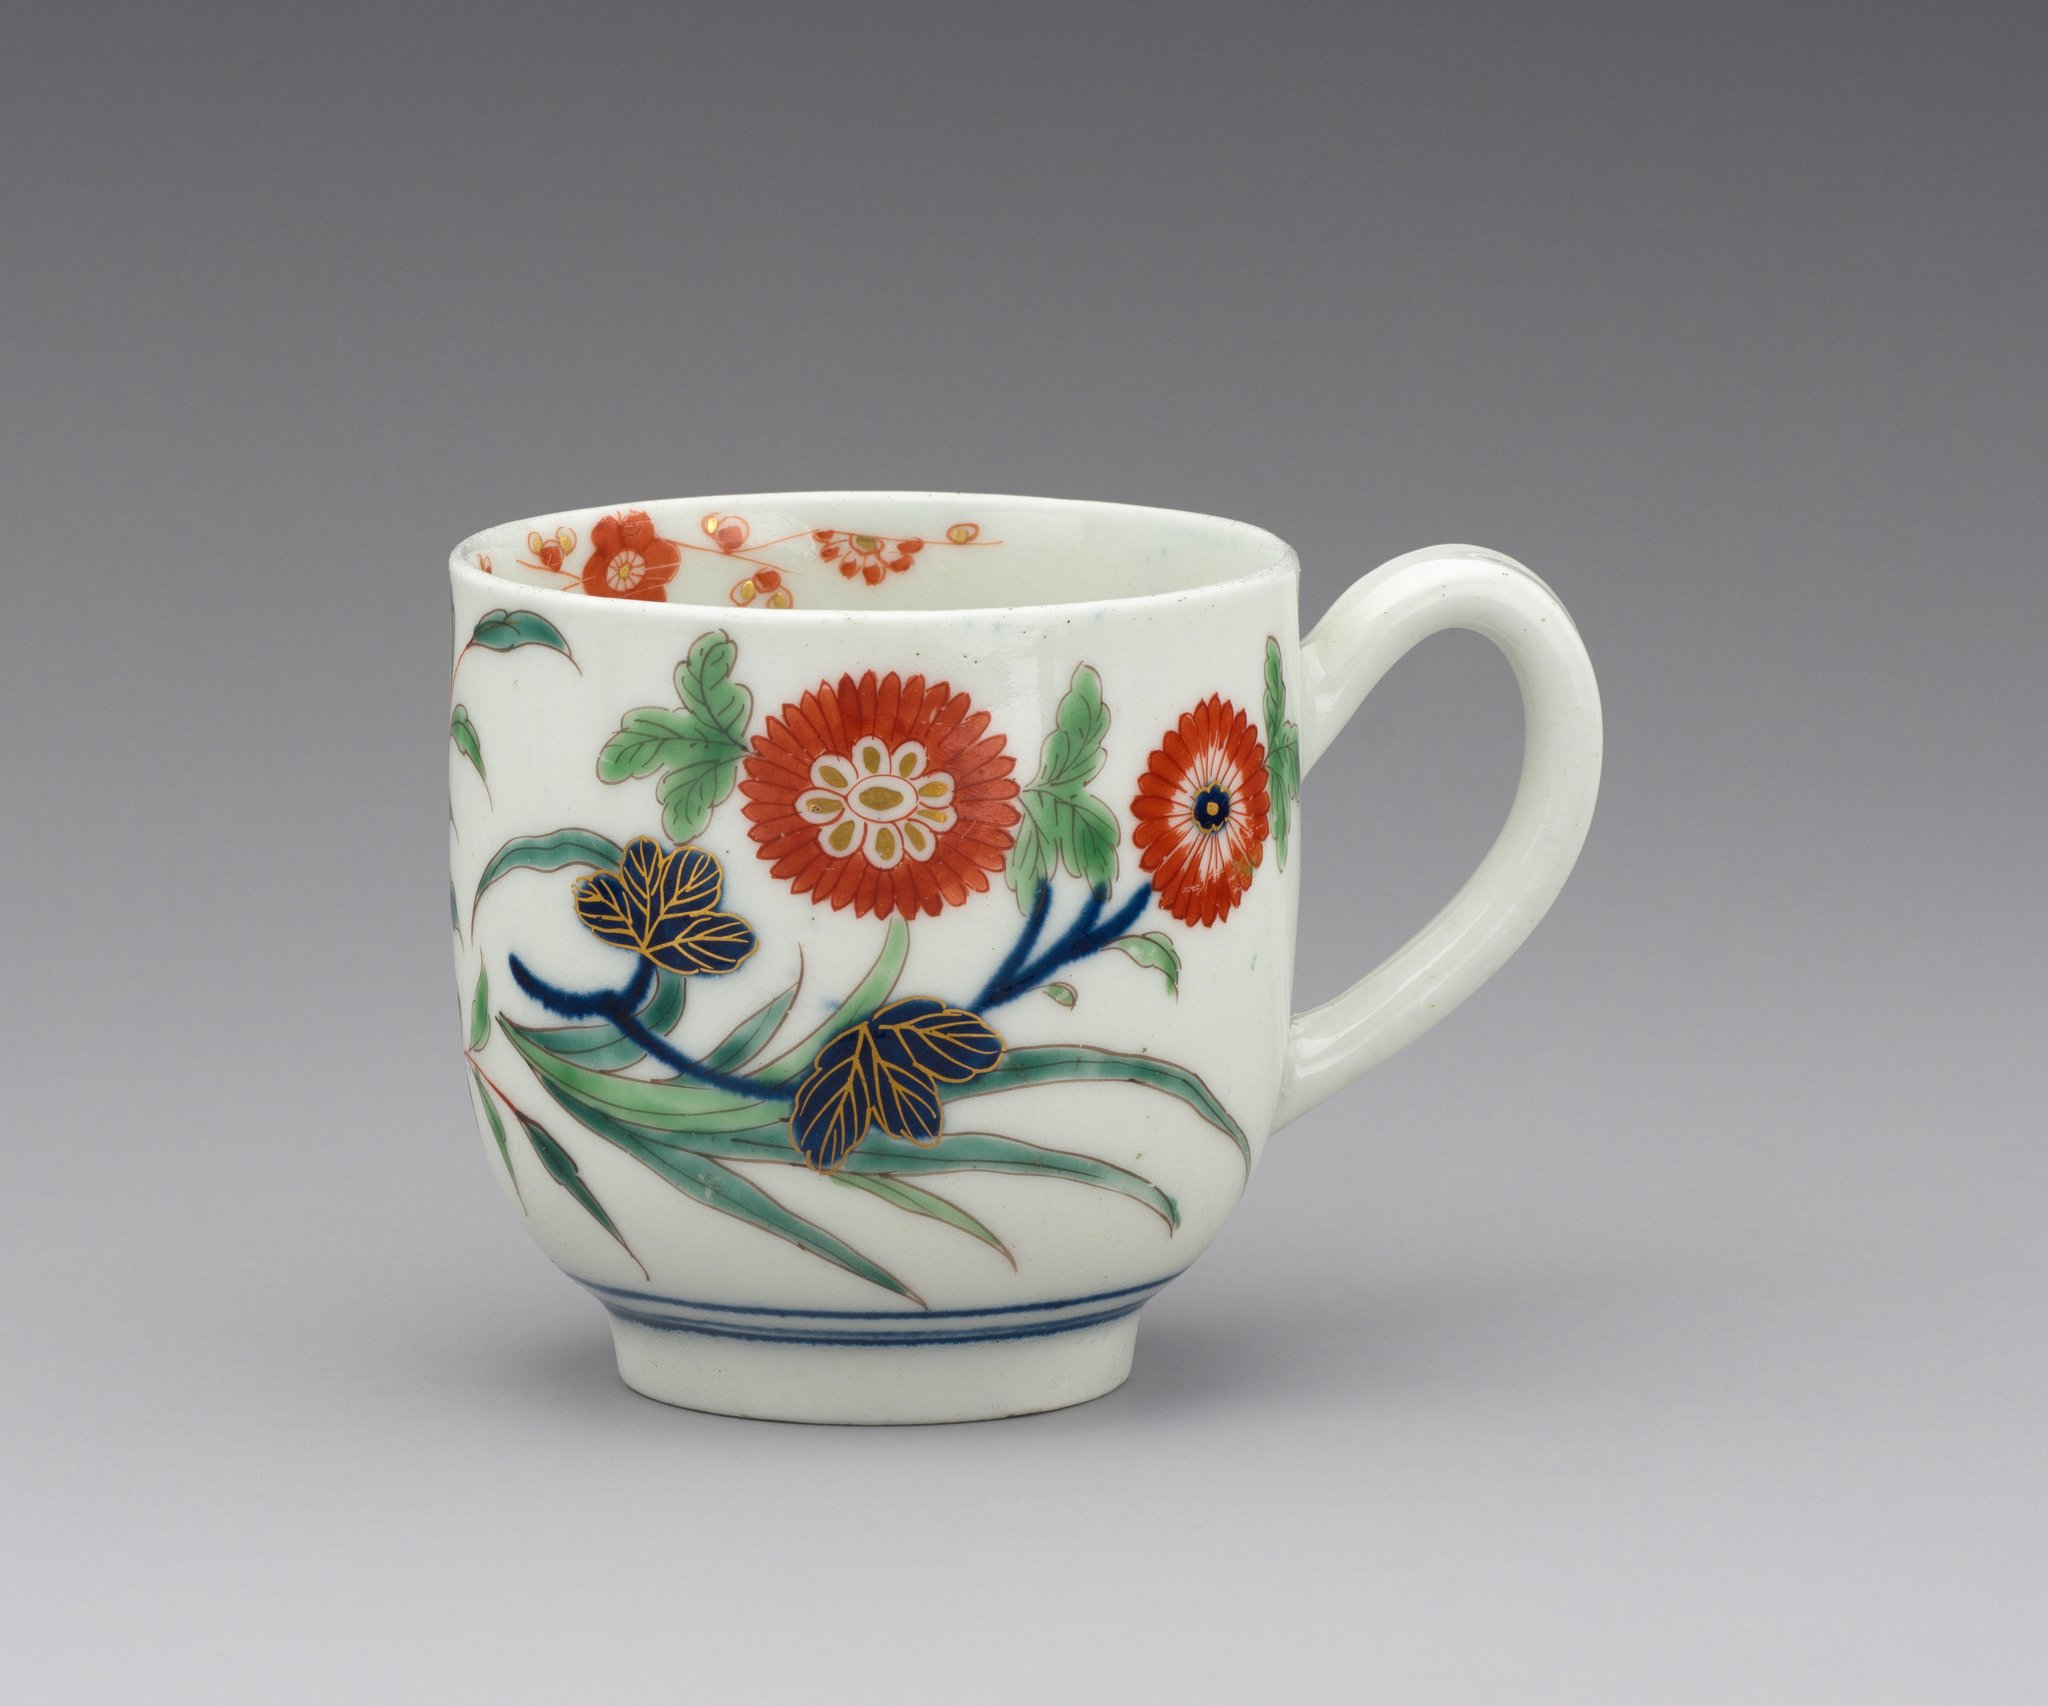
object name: chocolate cup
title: Chocolate cup (part of a service)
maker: worcester factory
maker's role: factory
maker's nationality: british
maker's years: 1751-2008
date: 1765-1770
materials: soft paste porcelain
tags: flowers